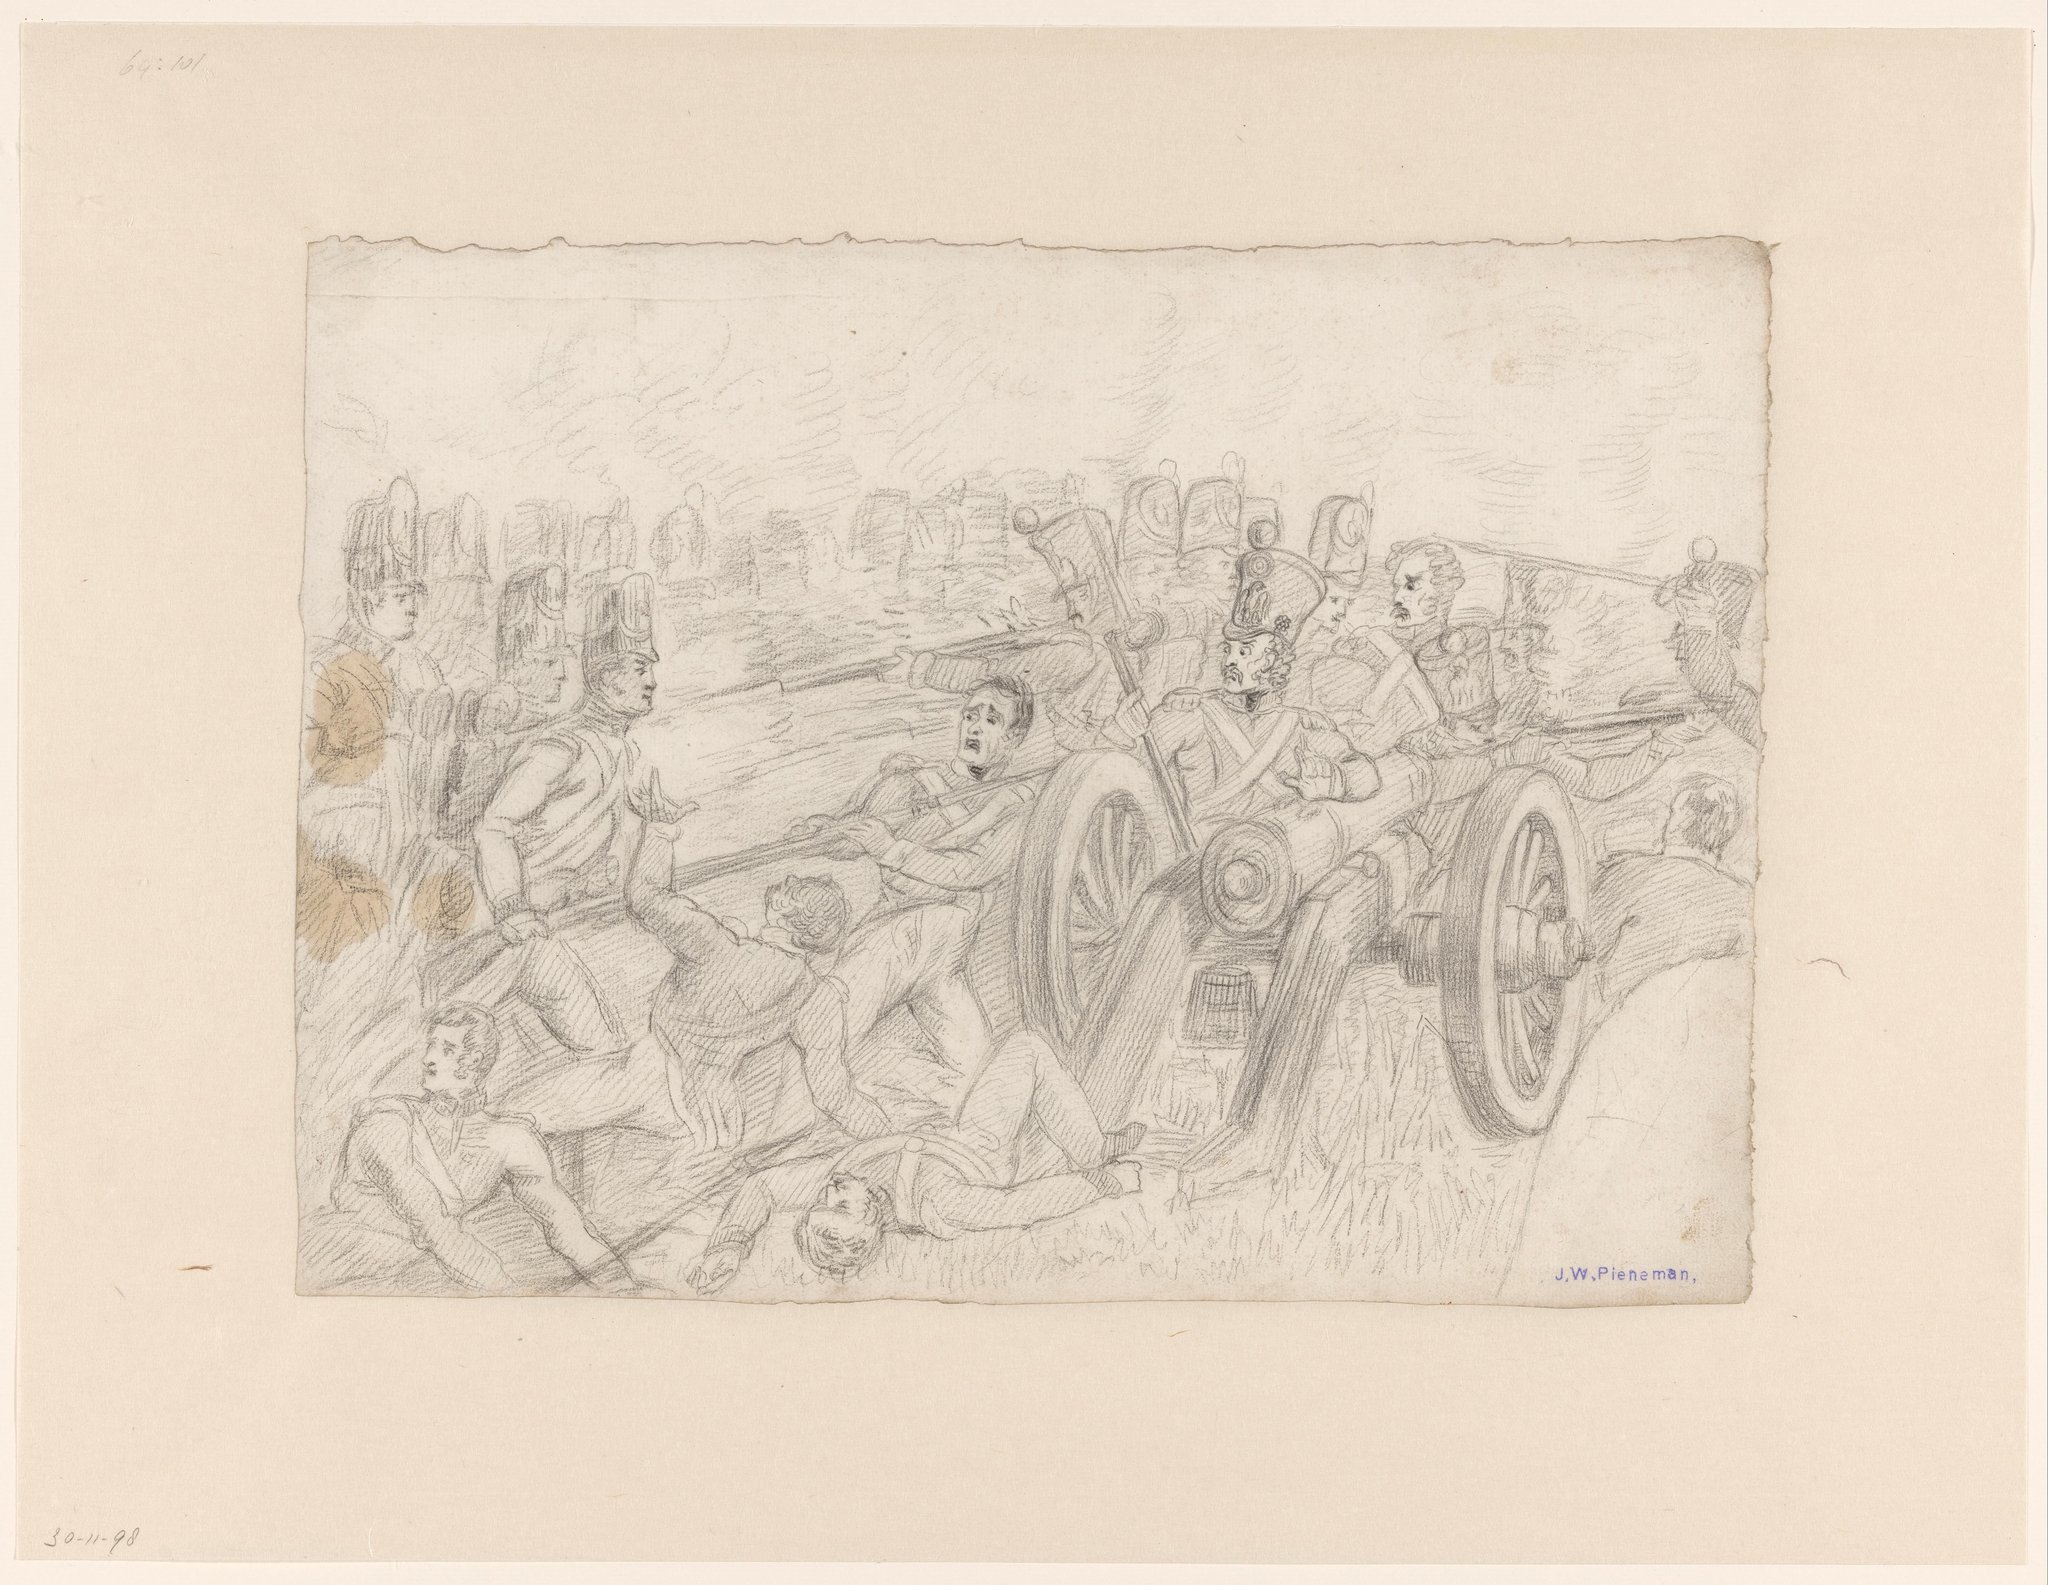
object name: drawing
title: Detail uit het schilderij De Slag bij Waterloo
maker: jan willem pieneman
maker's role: draughtsman, painter, print maker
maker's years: 1779-1853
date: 1789-1853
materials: chalk, paper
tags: battle (+ land forces), historical events and situations